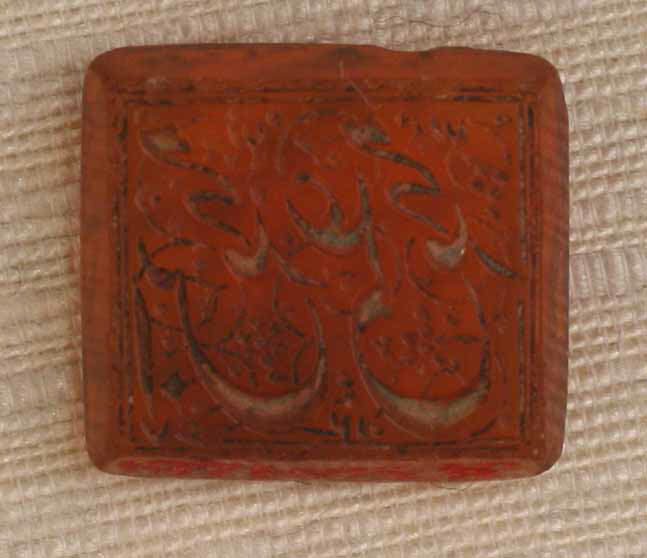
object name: stamp seal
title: Seal Stamp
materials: stone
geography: iran